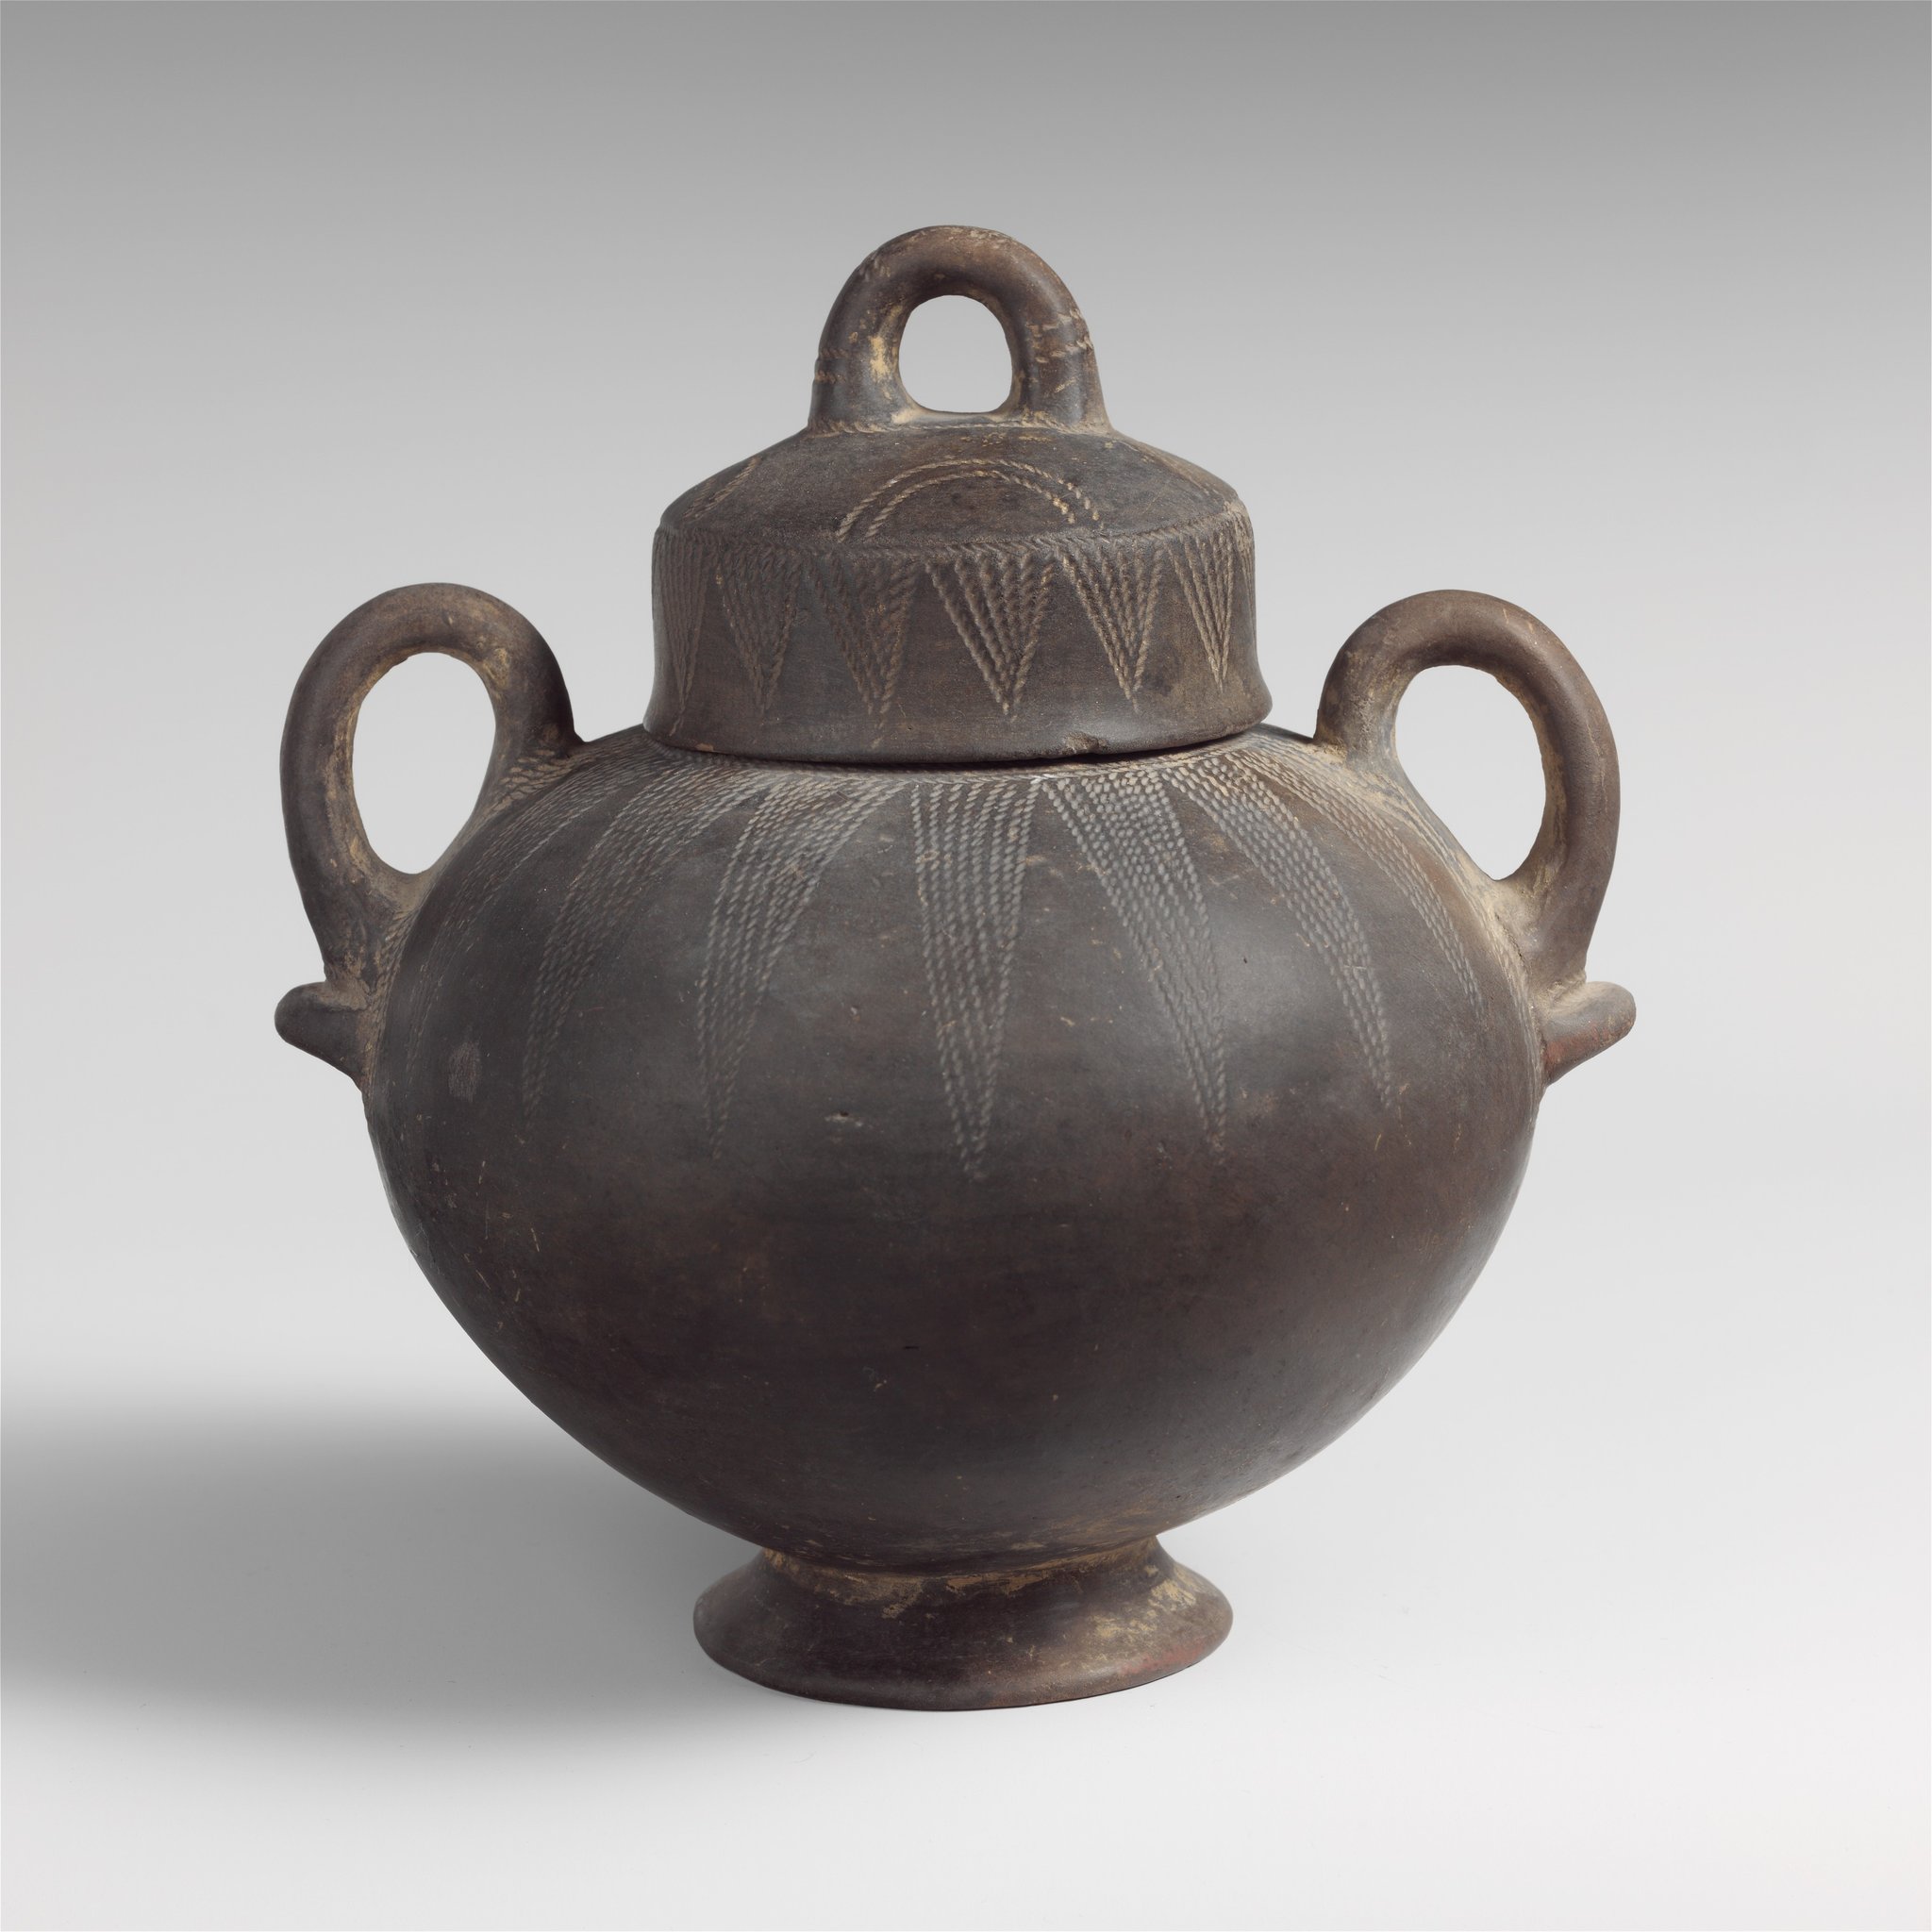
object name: vase with lid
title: Terracotta stamnoid cinerary urn with lid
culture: etruscan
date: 650-600 BCE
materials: terracotta